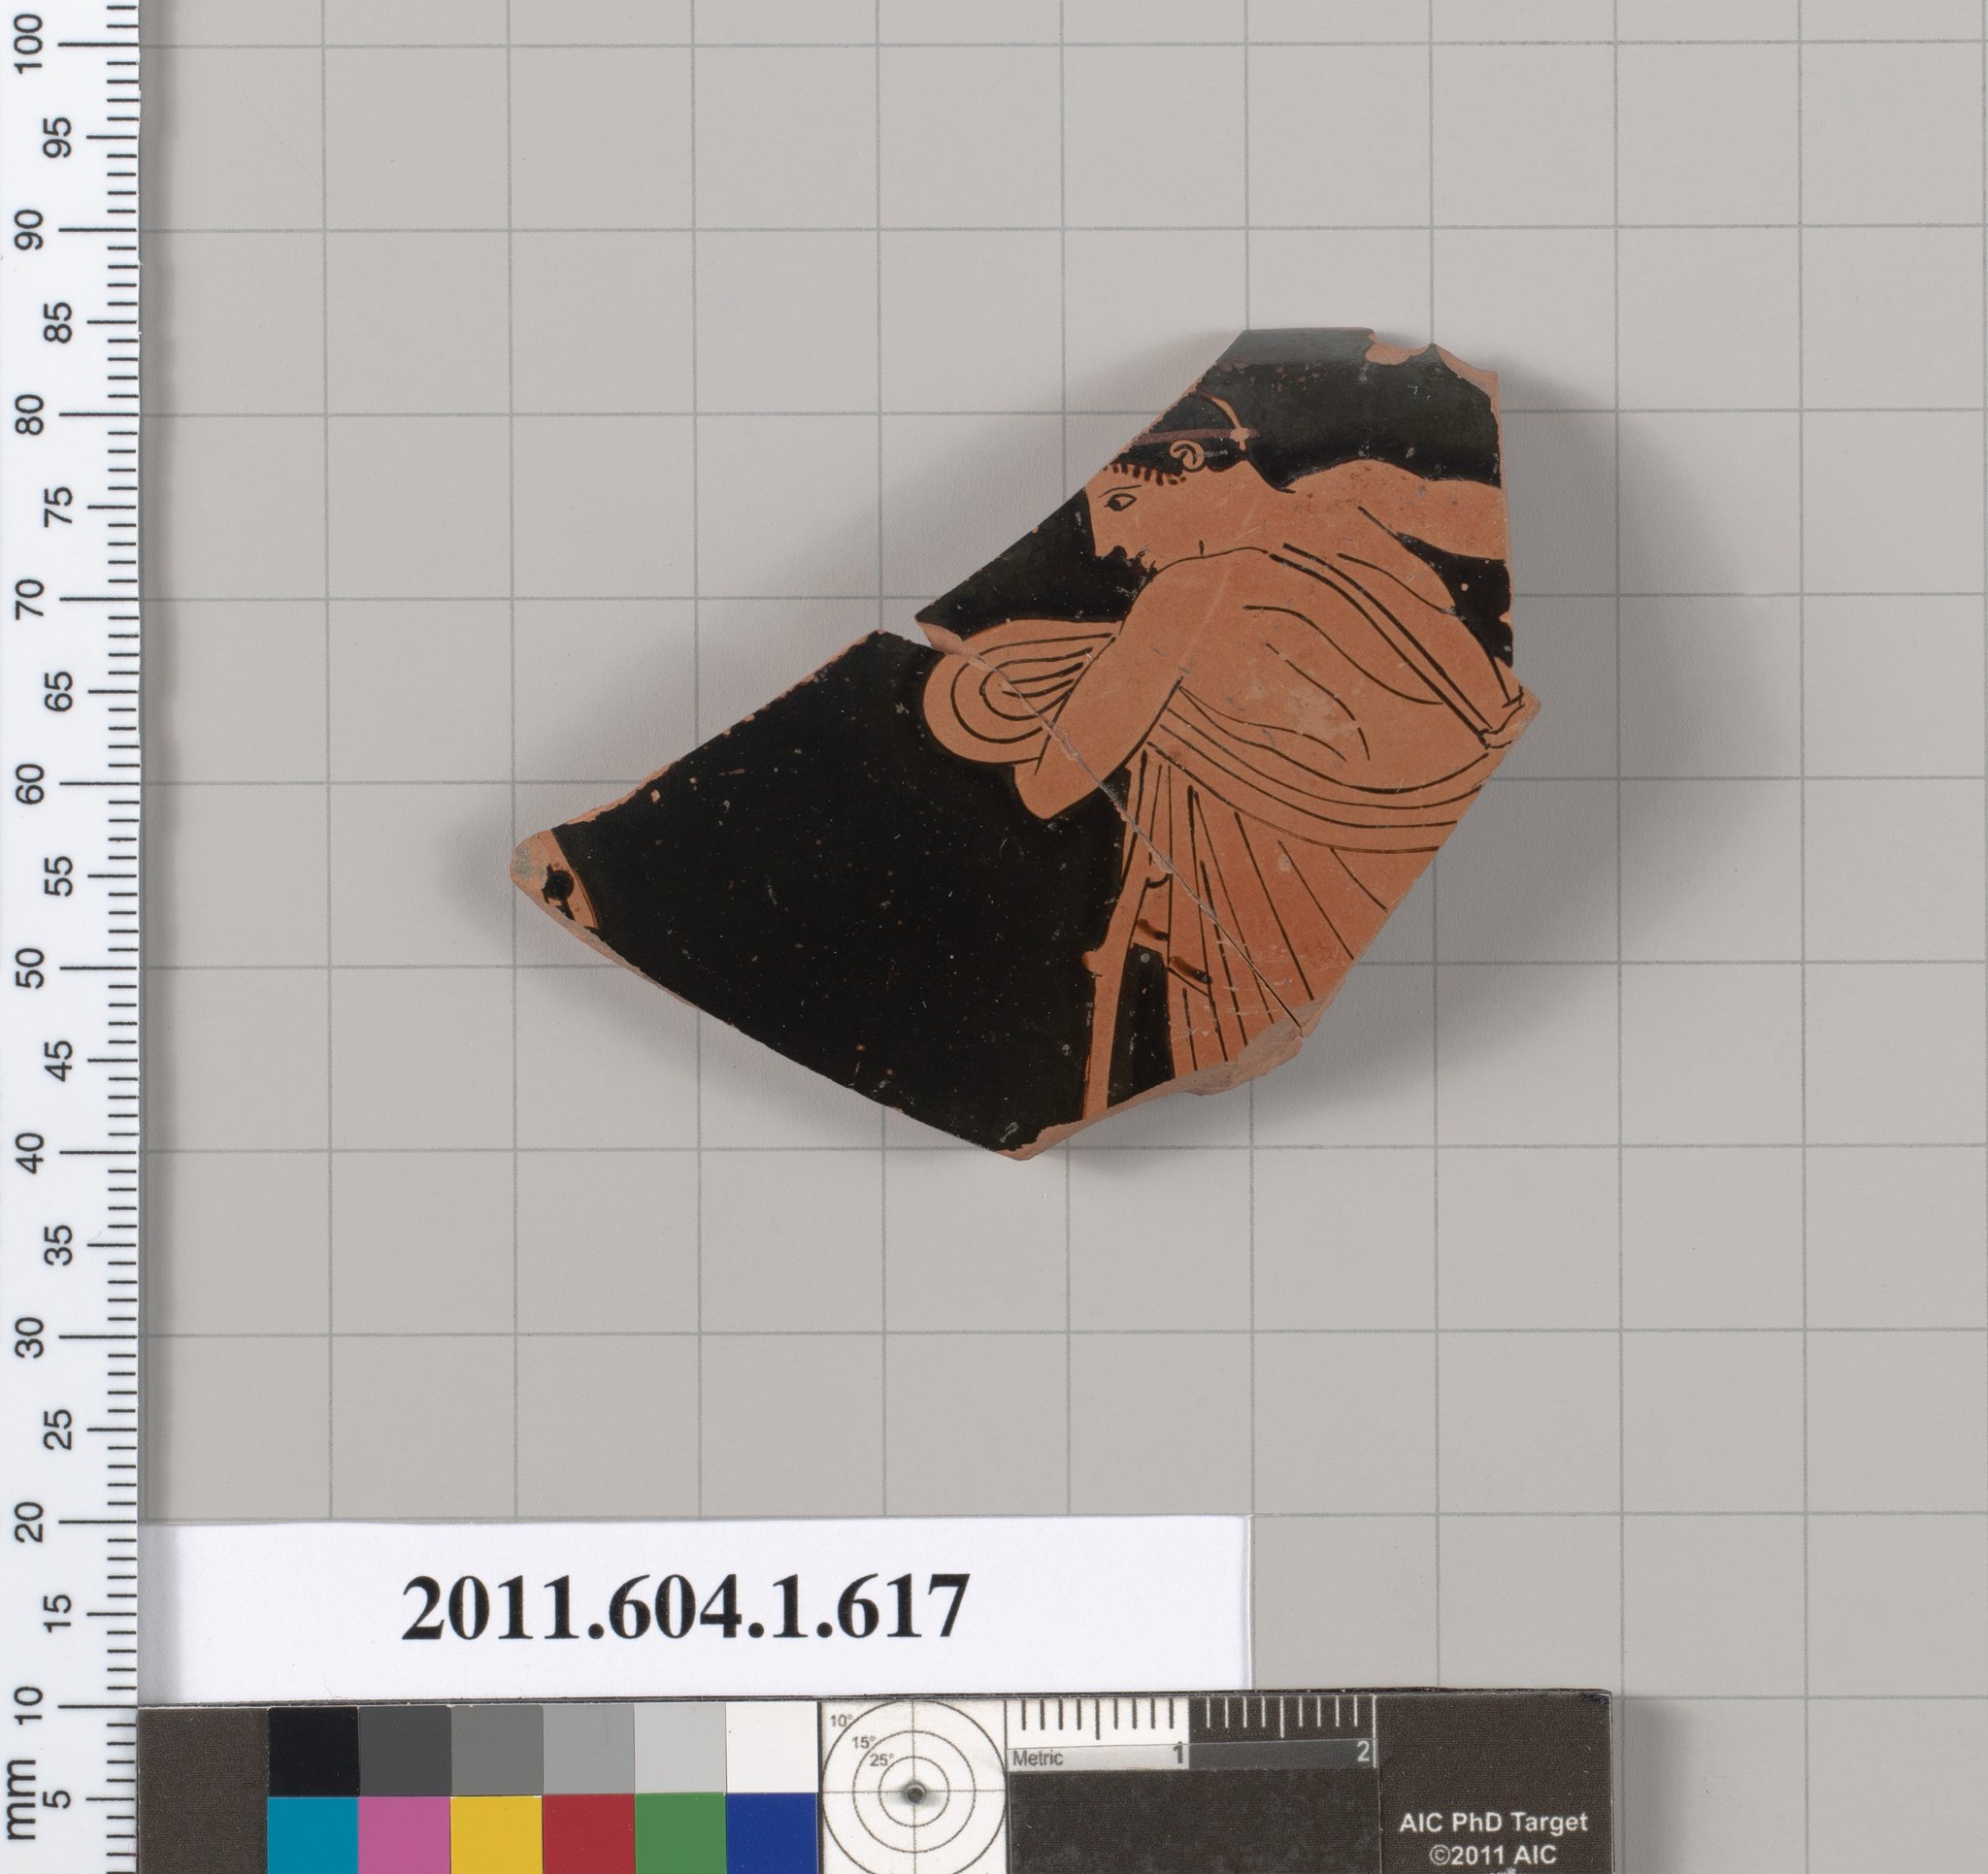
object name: kylix fragment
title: Terracotta rim fragment of a kylix (drinking cup)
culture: greek, attic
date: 475-451 BCE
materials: terracotta